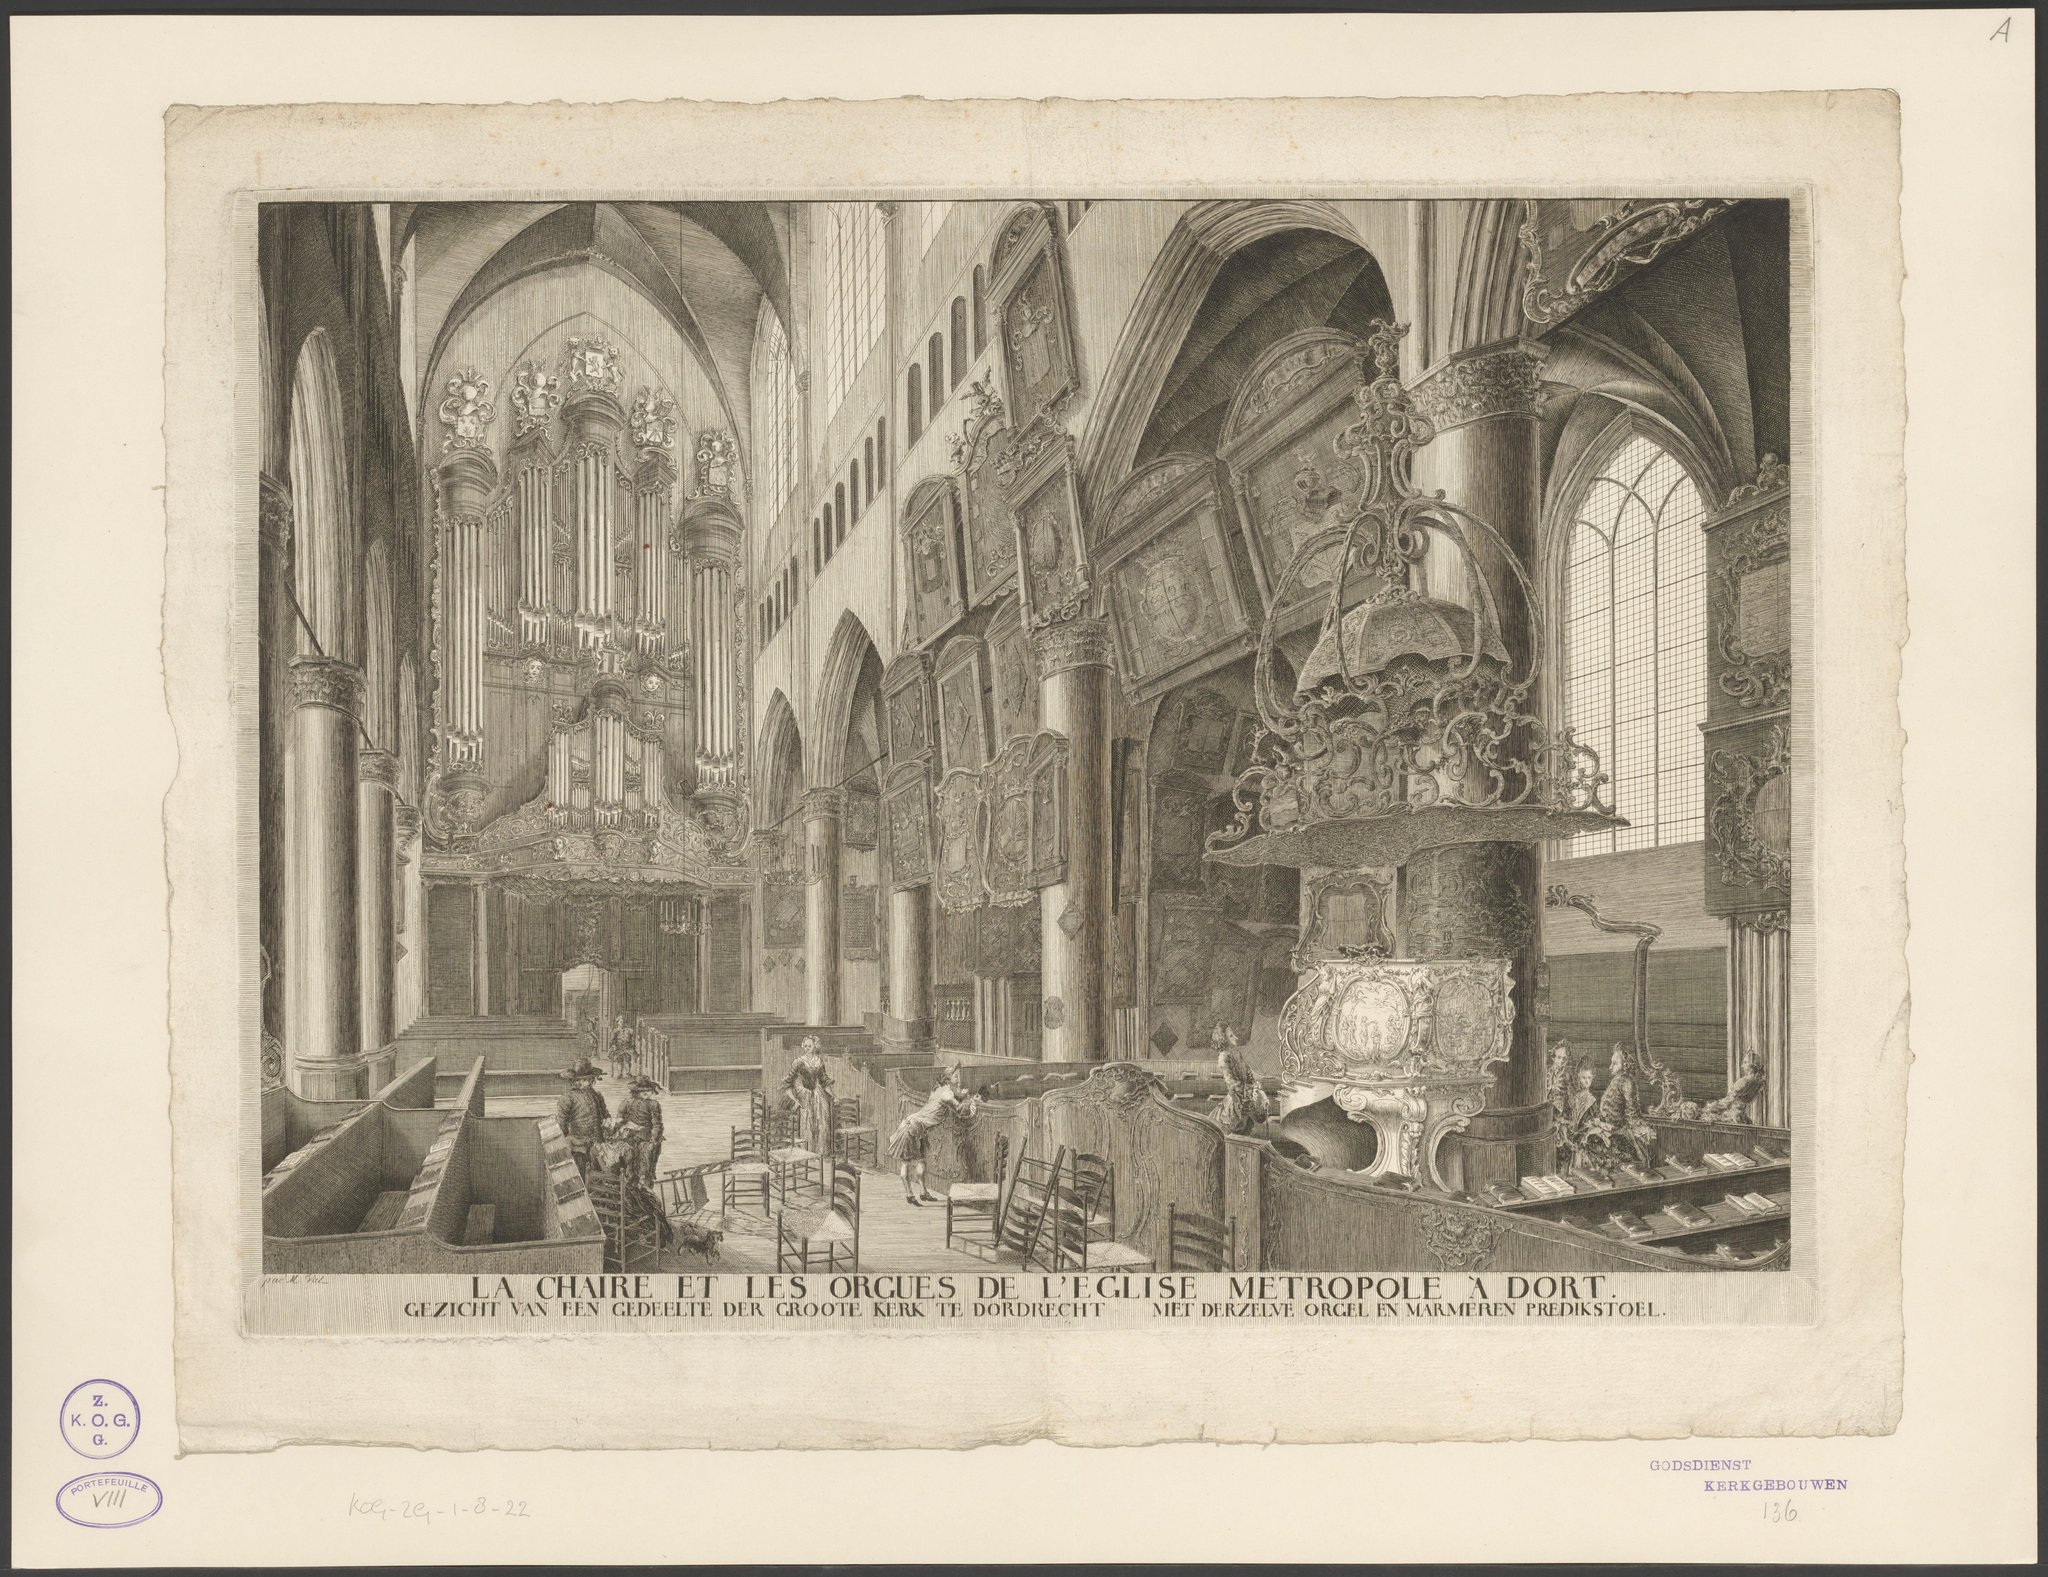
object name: print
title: La chaire et les orgues de l'eglise metropole à Dort / Gezicht van een gedeelte der Groote Kerk te Dordrecht met derzelve orgel en marmeren predikstoel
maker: auguste moreau val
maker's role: draughtsman, print maker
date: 1770-1775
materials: paper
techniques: engraving, etching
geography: netherlands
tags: church (exterior), church organ, pulpit, ambo, chancel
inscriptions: collector's mark, collector's mark: Lugt 1641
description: Interieur van de Grote Kerk te Dordrecht, met links het orgel en rechts van het midden de marmeren preekstoel. In de kerk verschillende figuren. Onderwerpsrubrieken binnen de Atlas Zeden en Gewoonten: Kerk en kerkwezen & Armwezen en liefdadige instellingen; Kerkgebouwen elders. A-E.